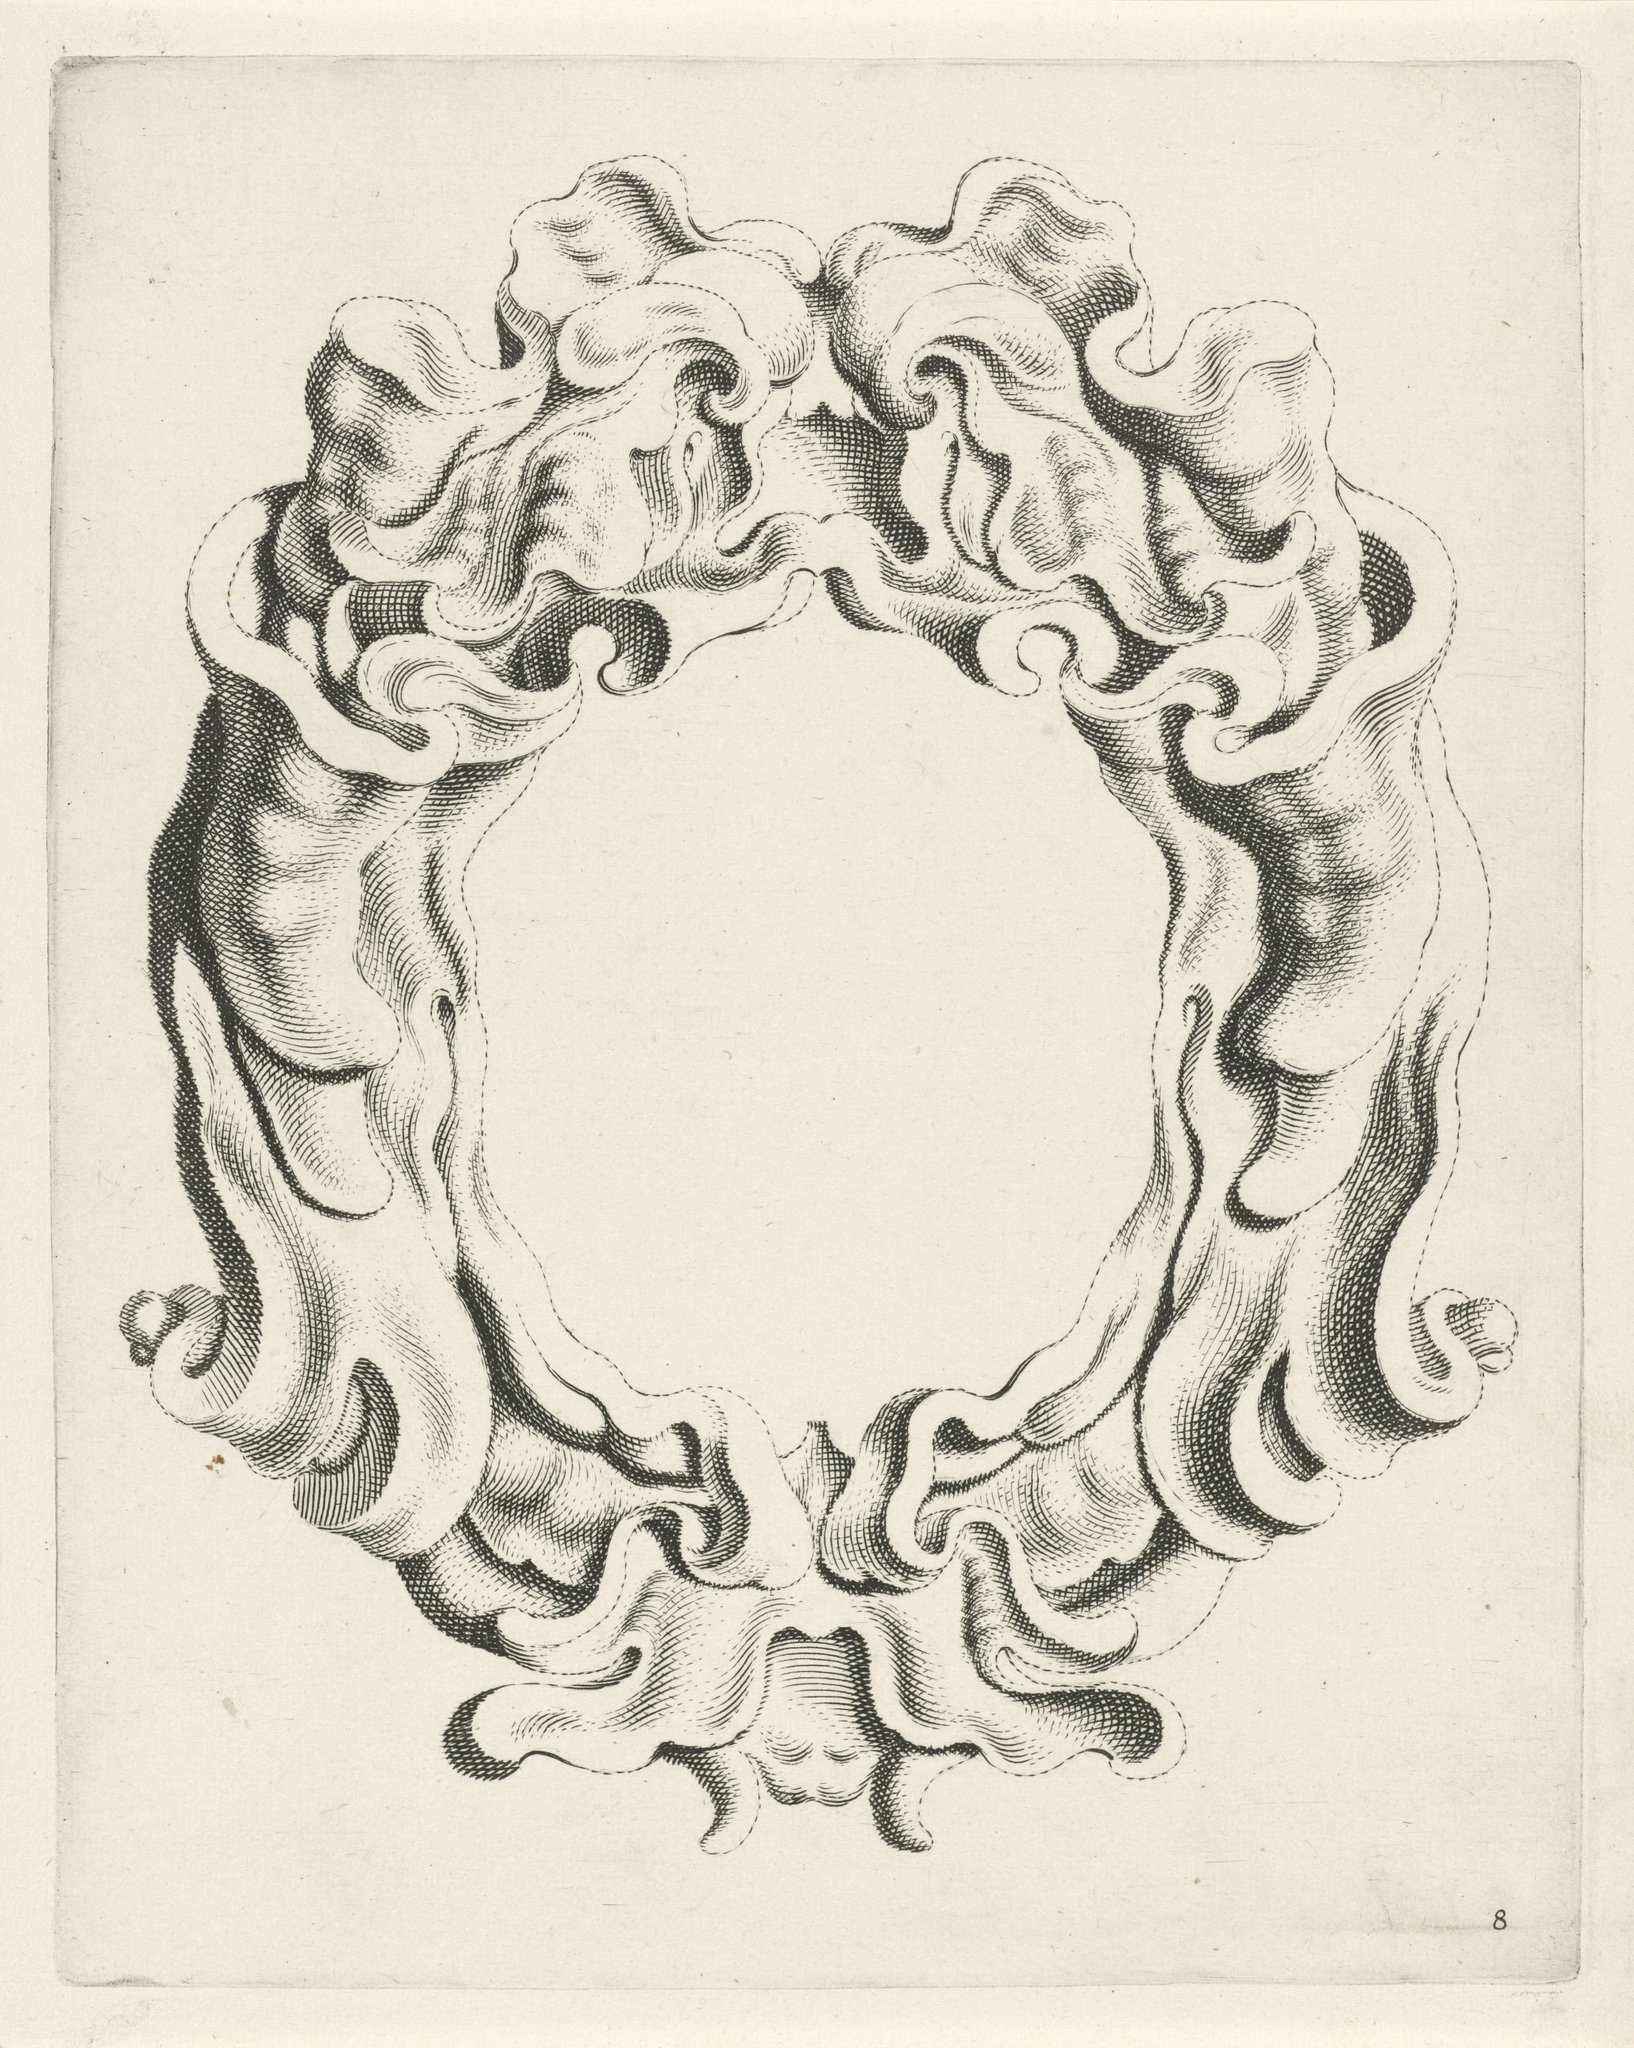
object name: ornament print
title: Veelderhande Niewe Compartemente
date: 1640-1655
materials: paper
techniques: engraving, etching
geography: amsterdam